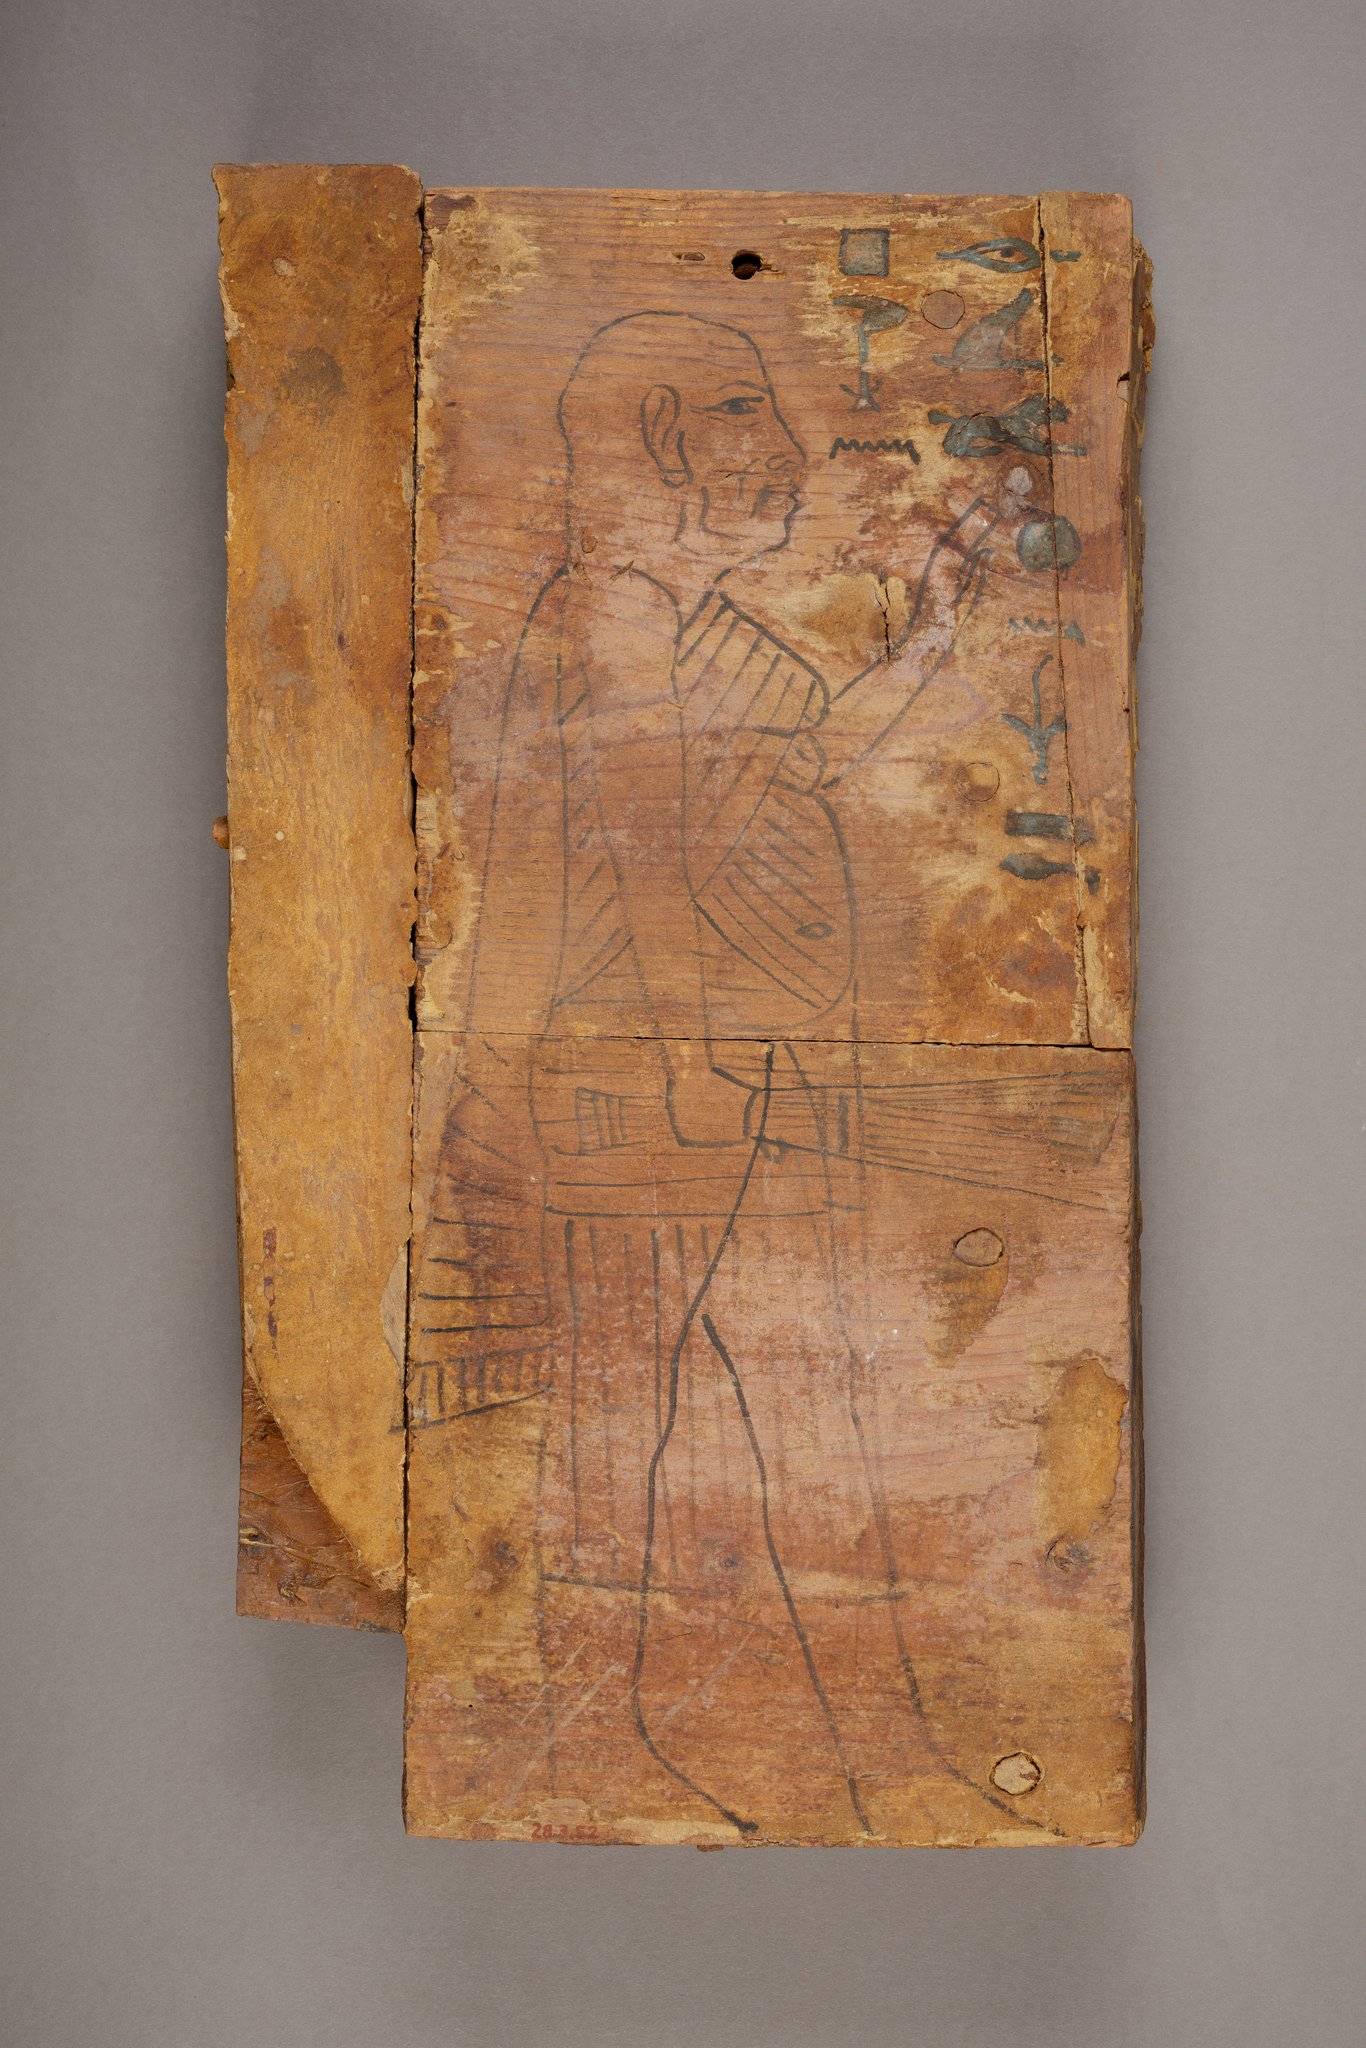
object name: coffin fragment, pakherenkhonsu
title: Coffin fragment of Pakherenkhonsu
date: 750-700 BCE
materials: ink, wood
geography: egypt